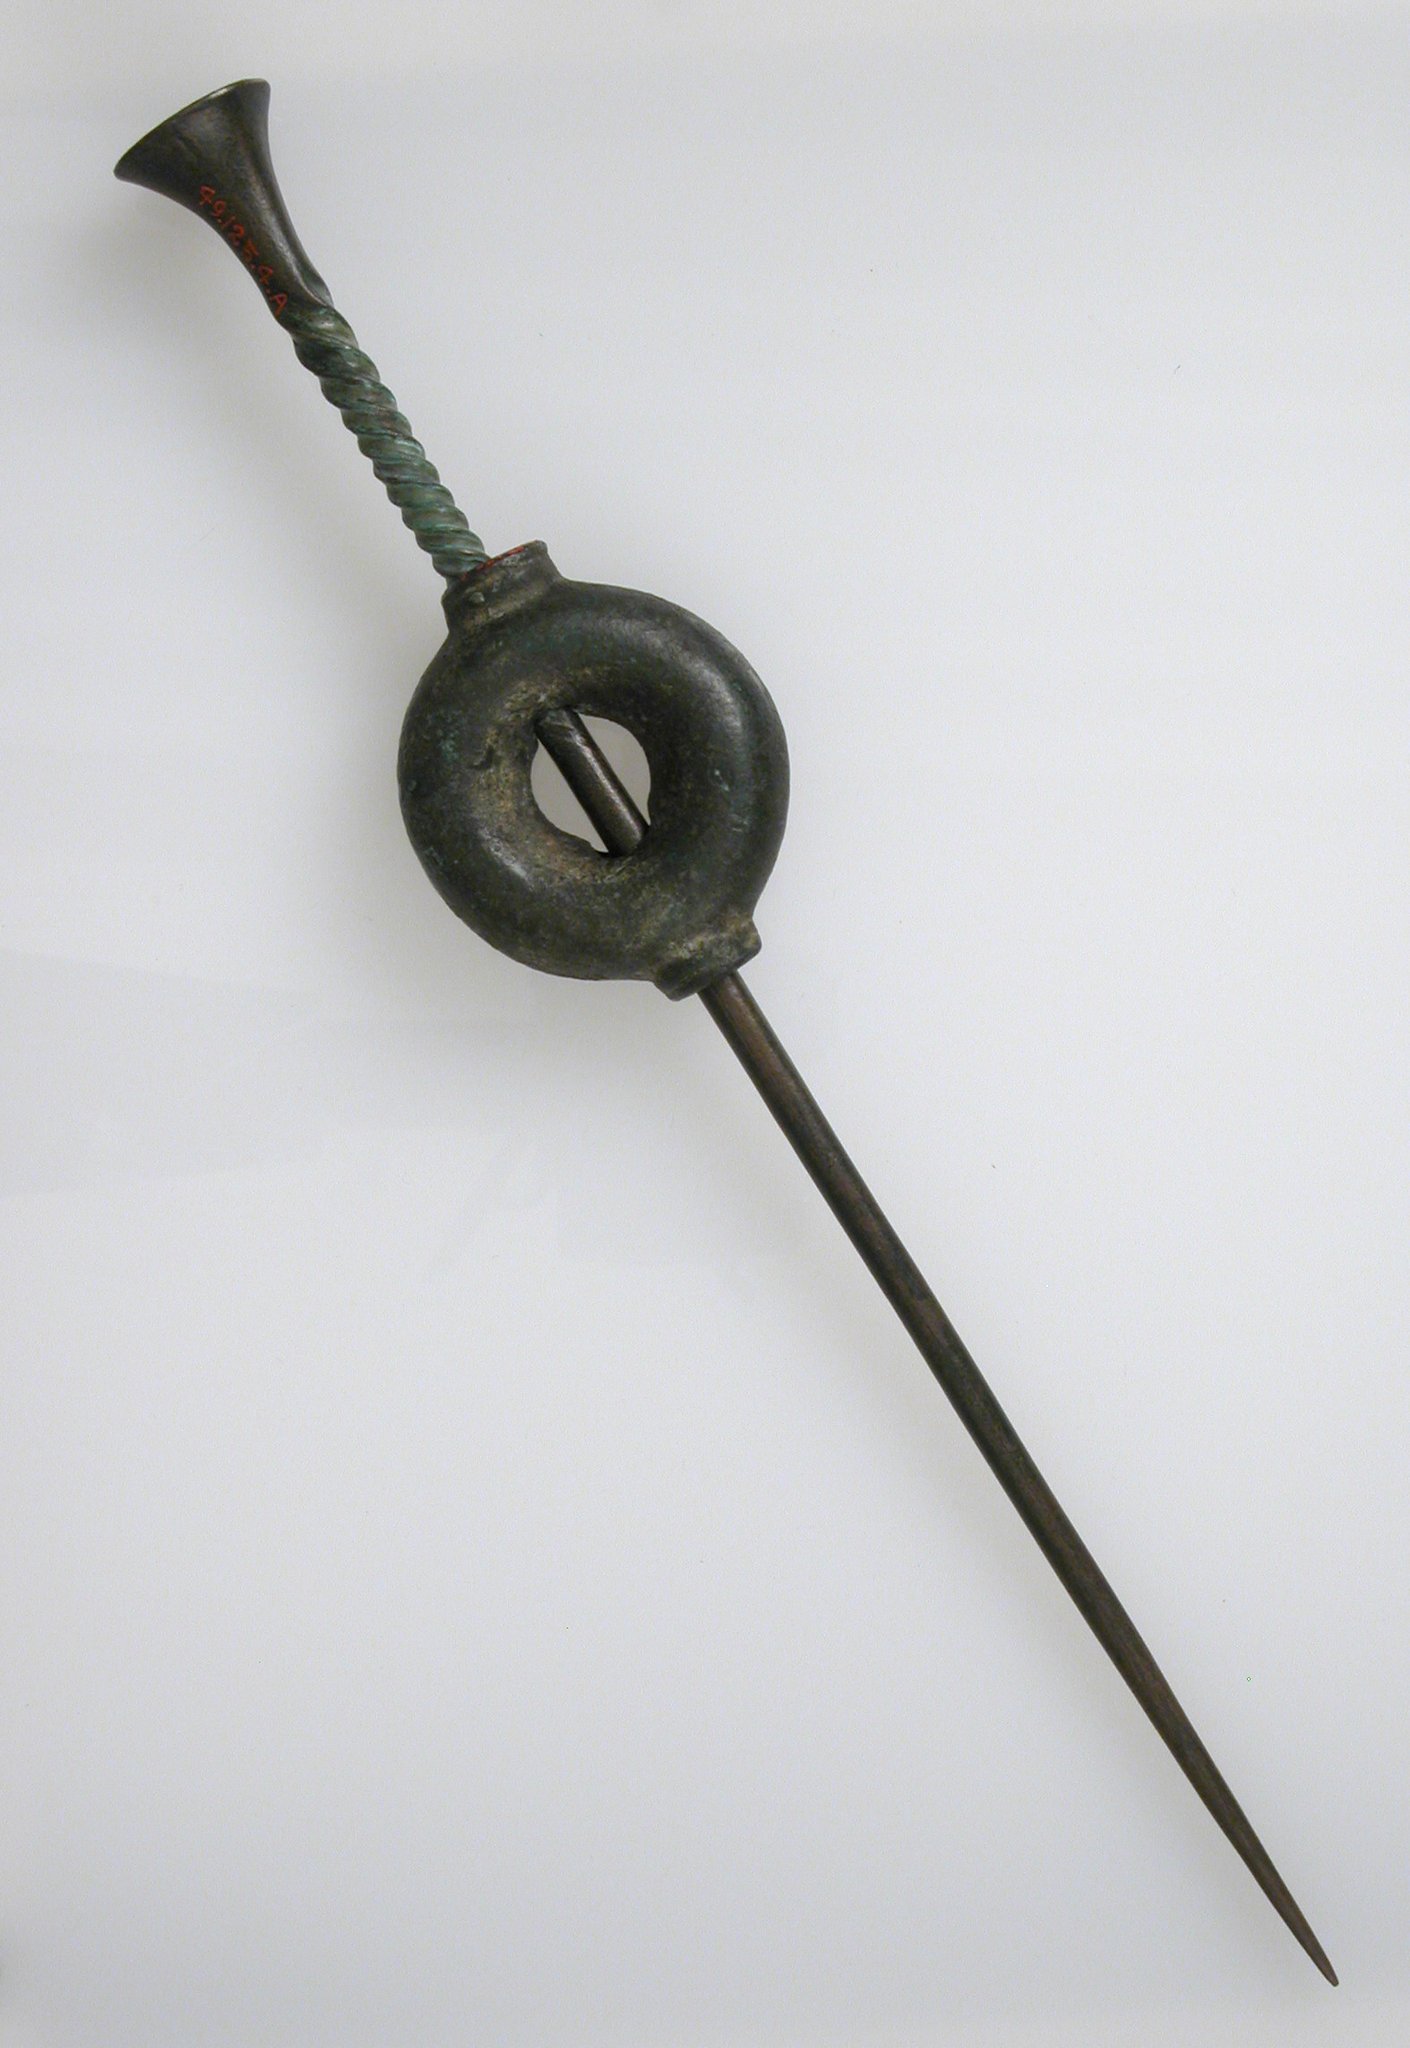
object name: pin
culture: irish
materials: copper alloy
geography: ireland